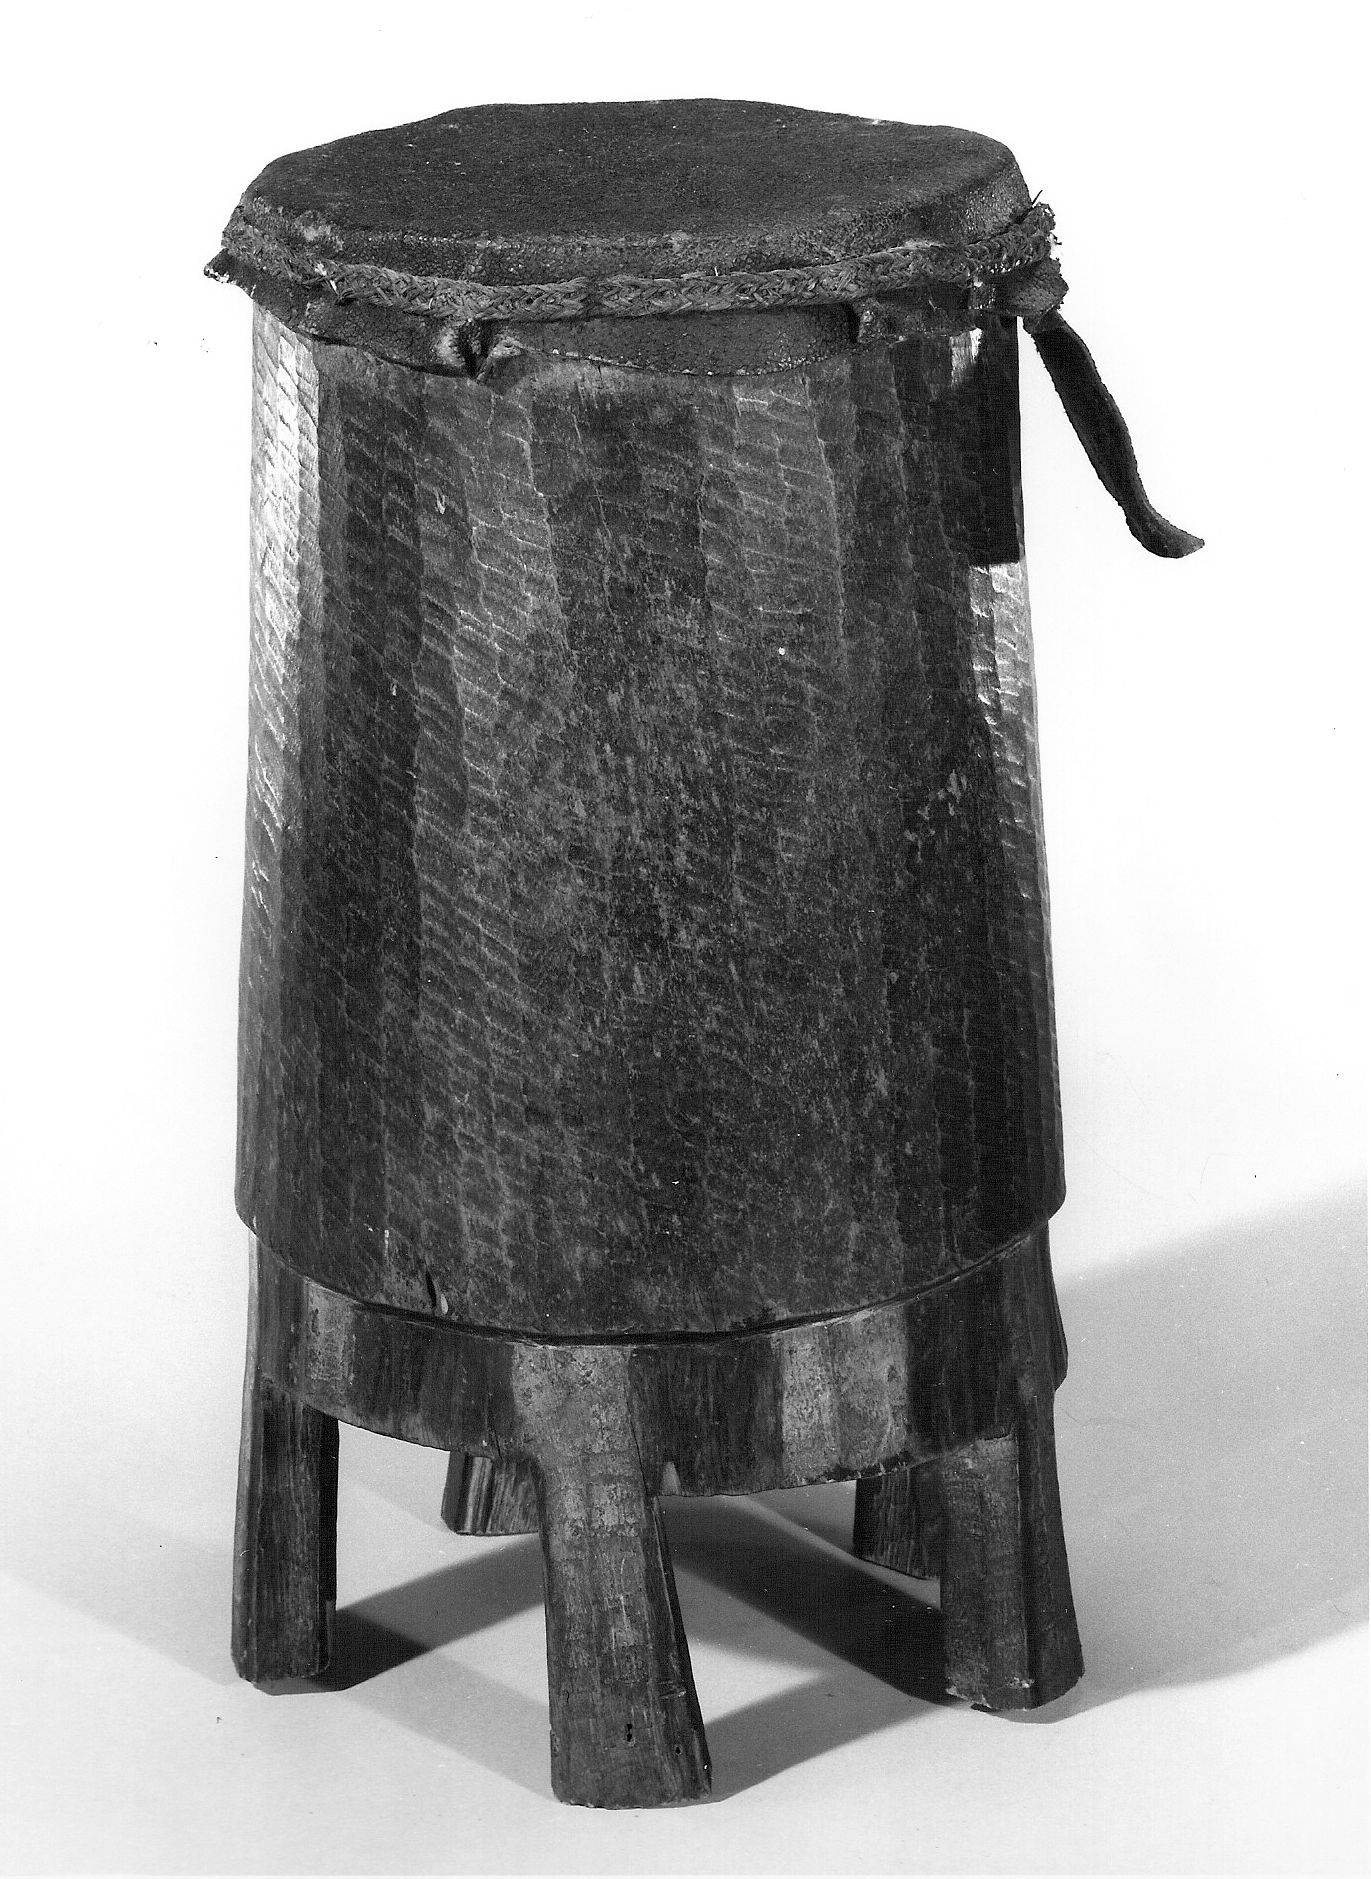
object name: drum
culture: poto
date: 1801-1900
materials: rattan, wood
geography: democratic republic of the congo